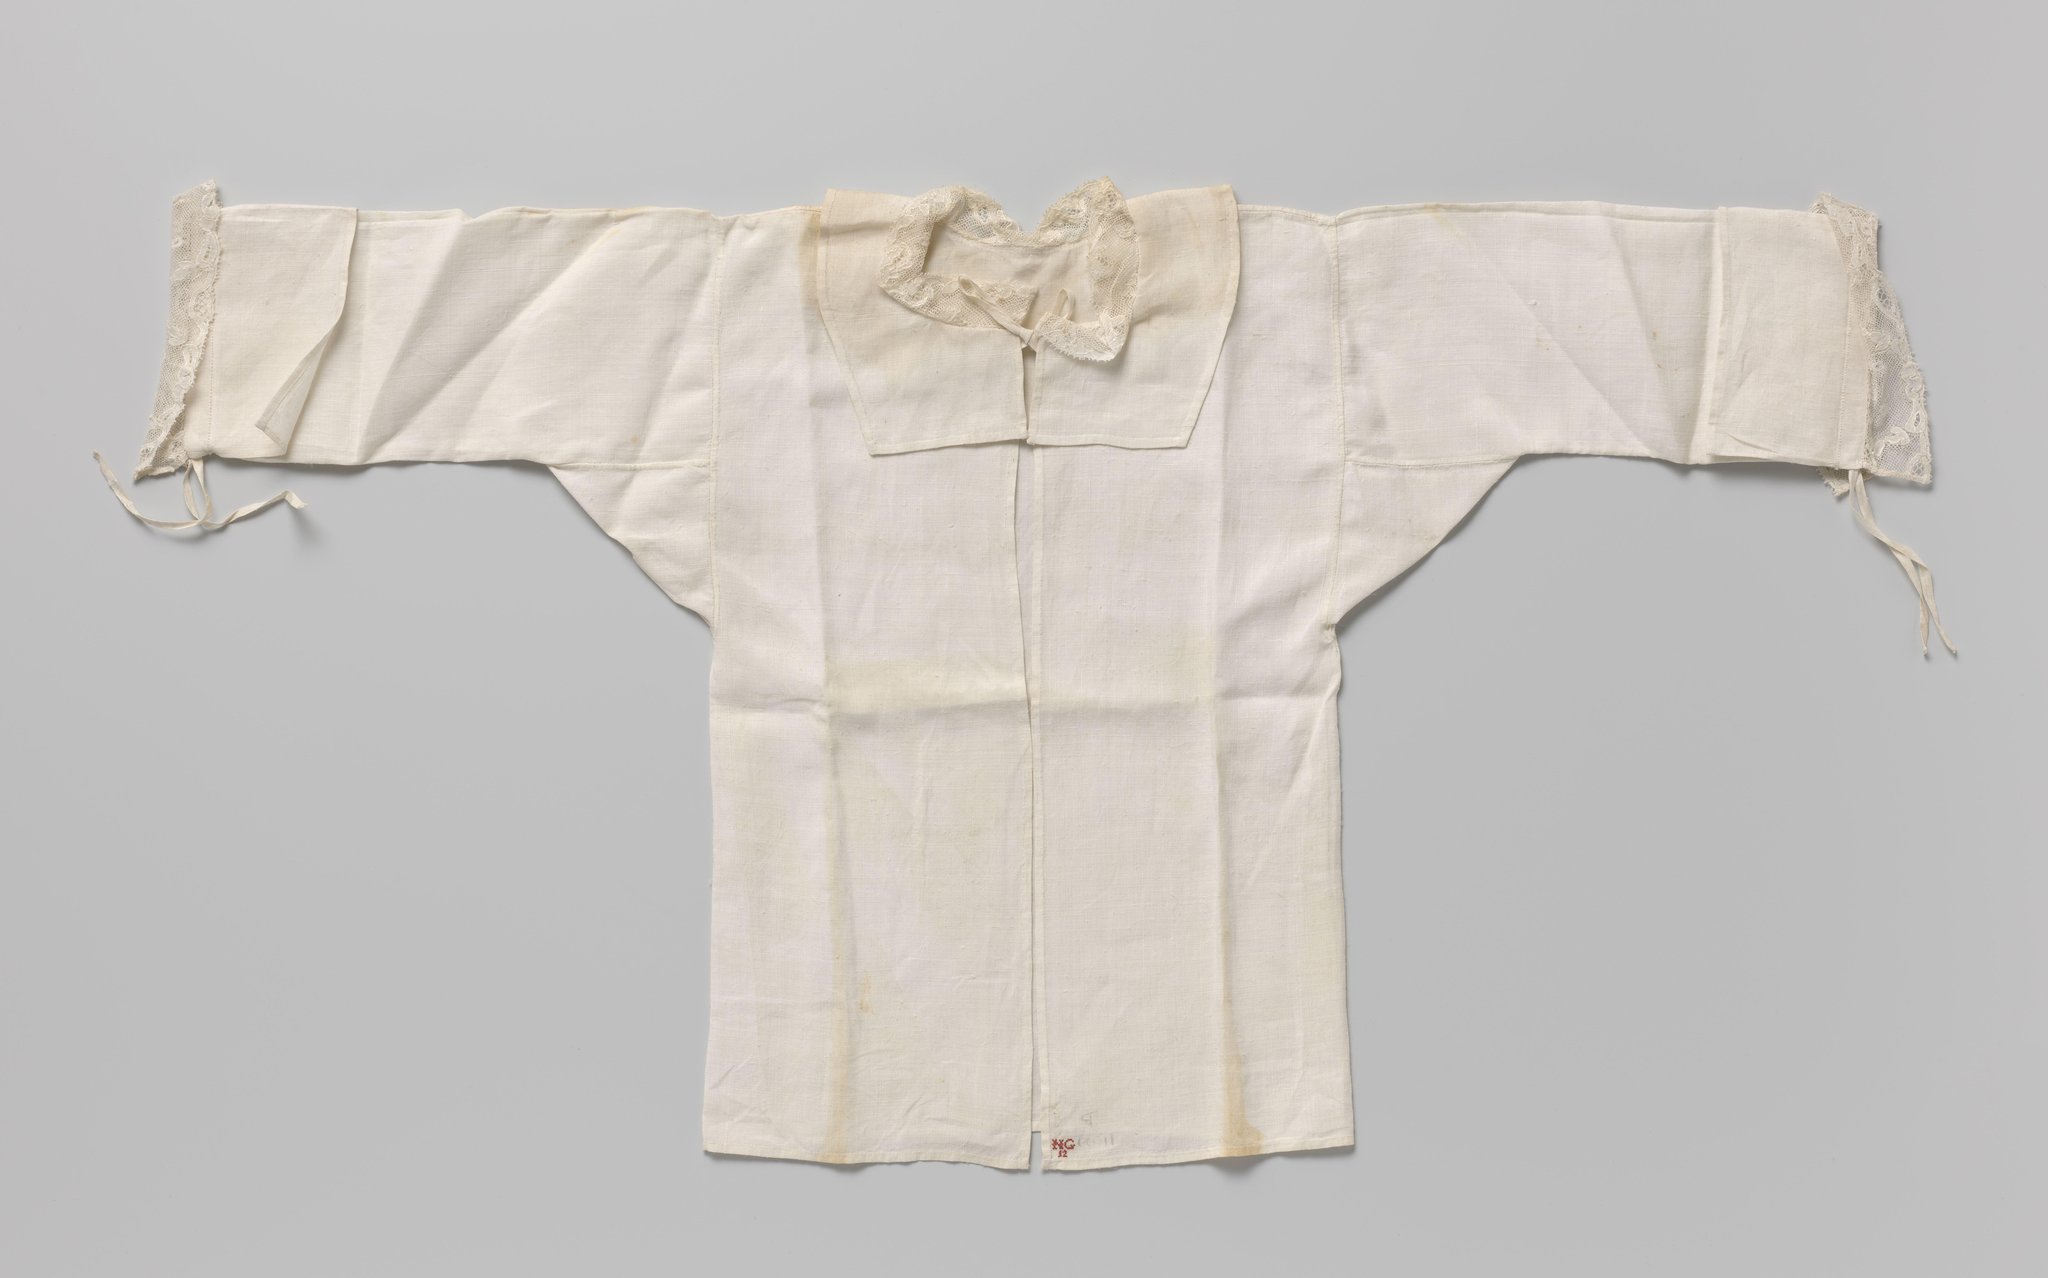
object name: chemise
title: Kinderhemd van wit linnen, met platte rechte kraag, doorgeregen striklinten, lange mouw en kantrand langs de hals; in rode kruissteek gemerkt: NG12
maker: Anonymous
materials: linen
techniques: cross stitching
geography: europe